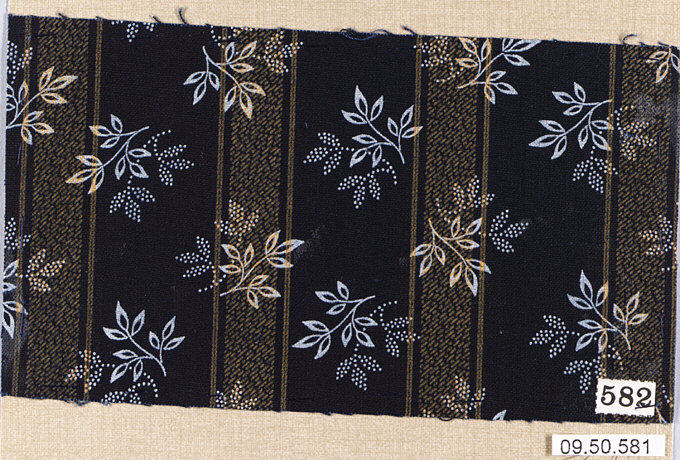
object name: piece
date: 1801-1900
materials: cotton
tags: leaves